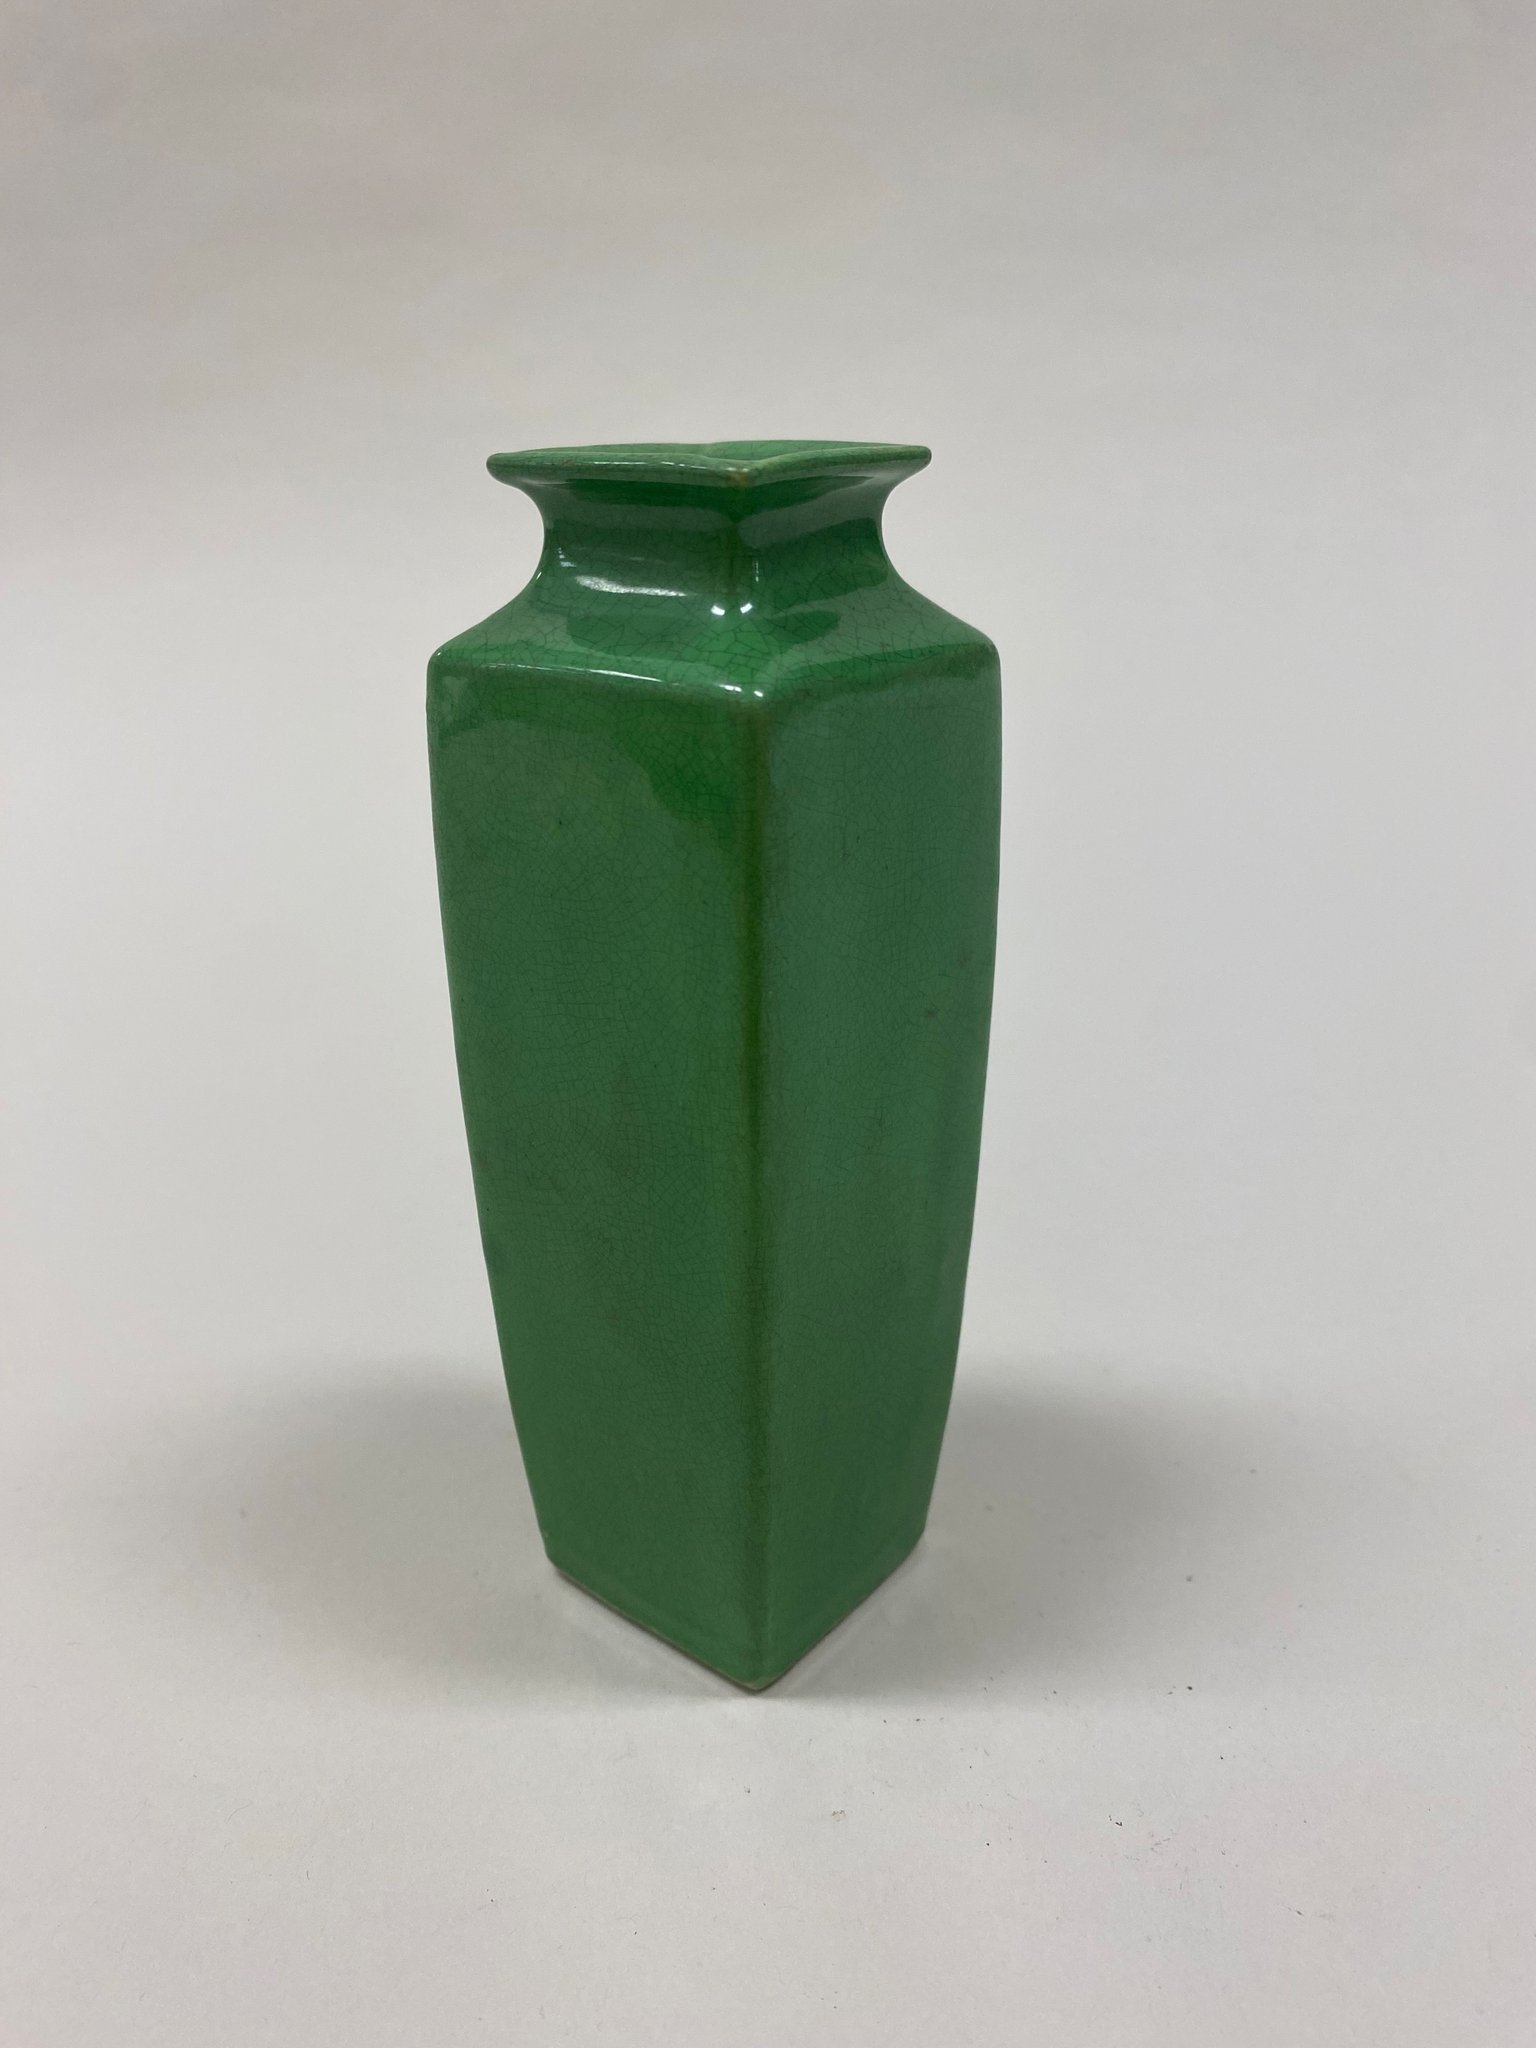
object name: vase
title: Square vase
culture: chinese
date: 1767-1900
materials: glaze, porcelain